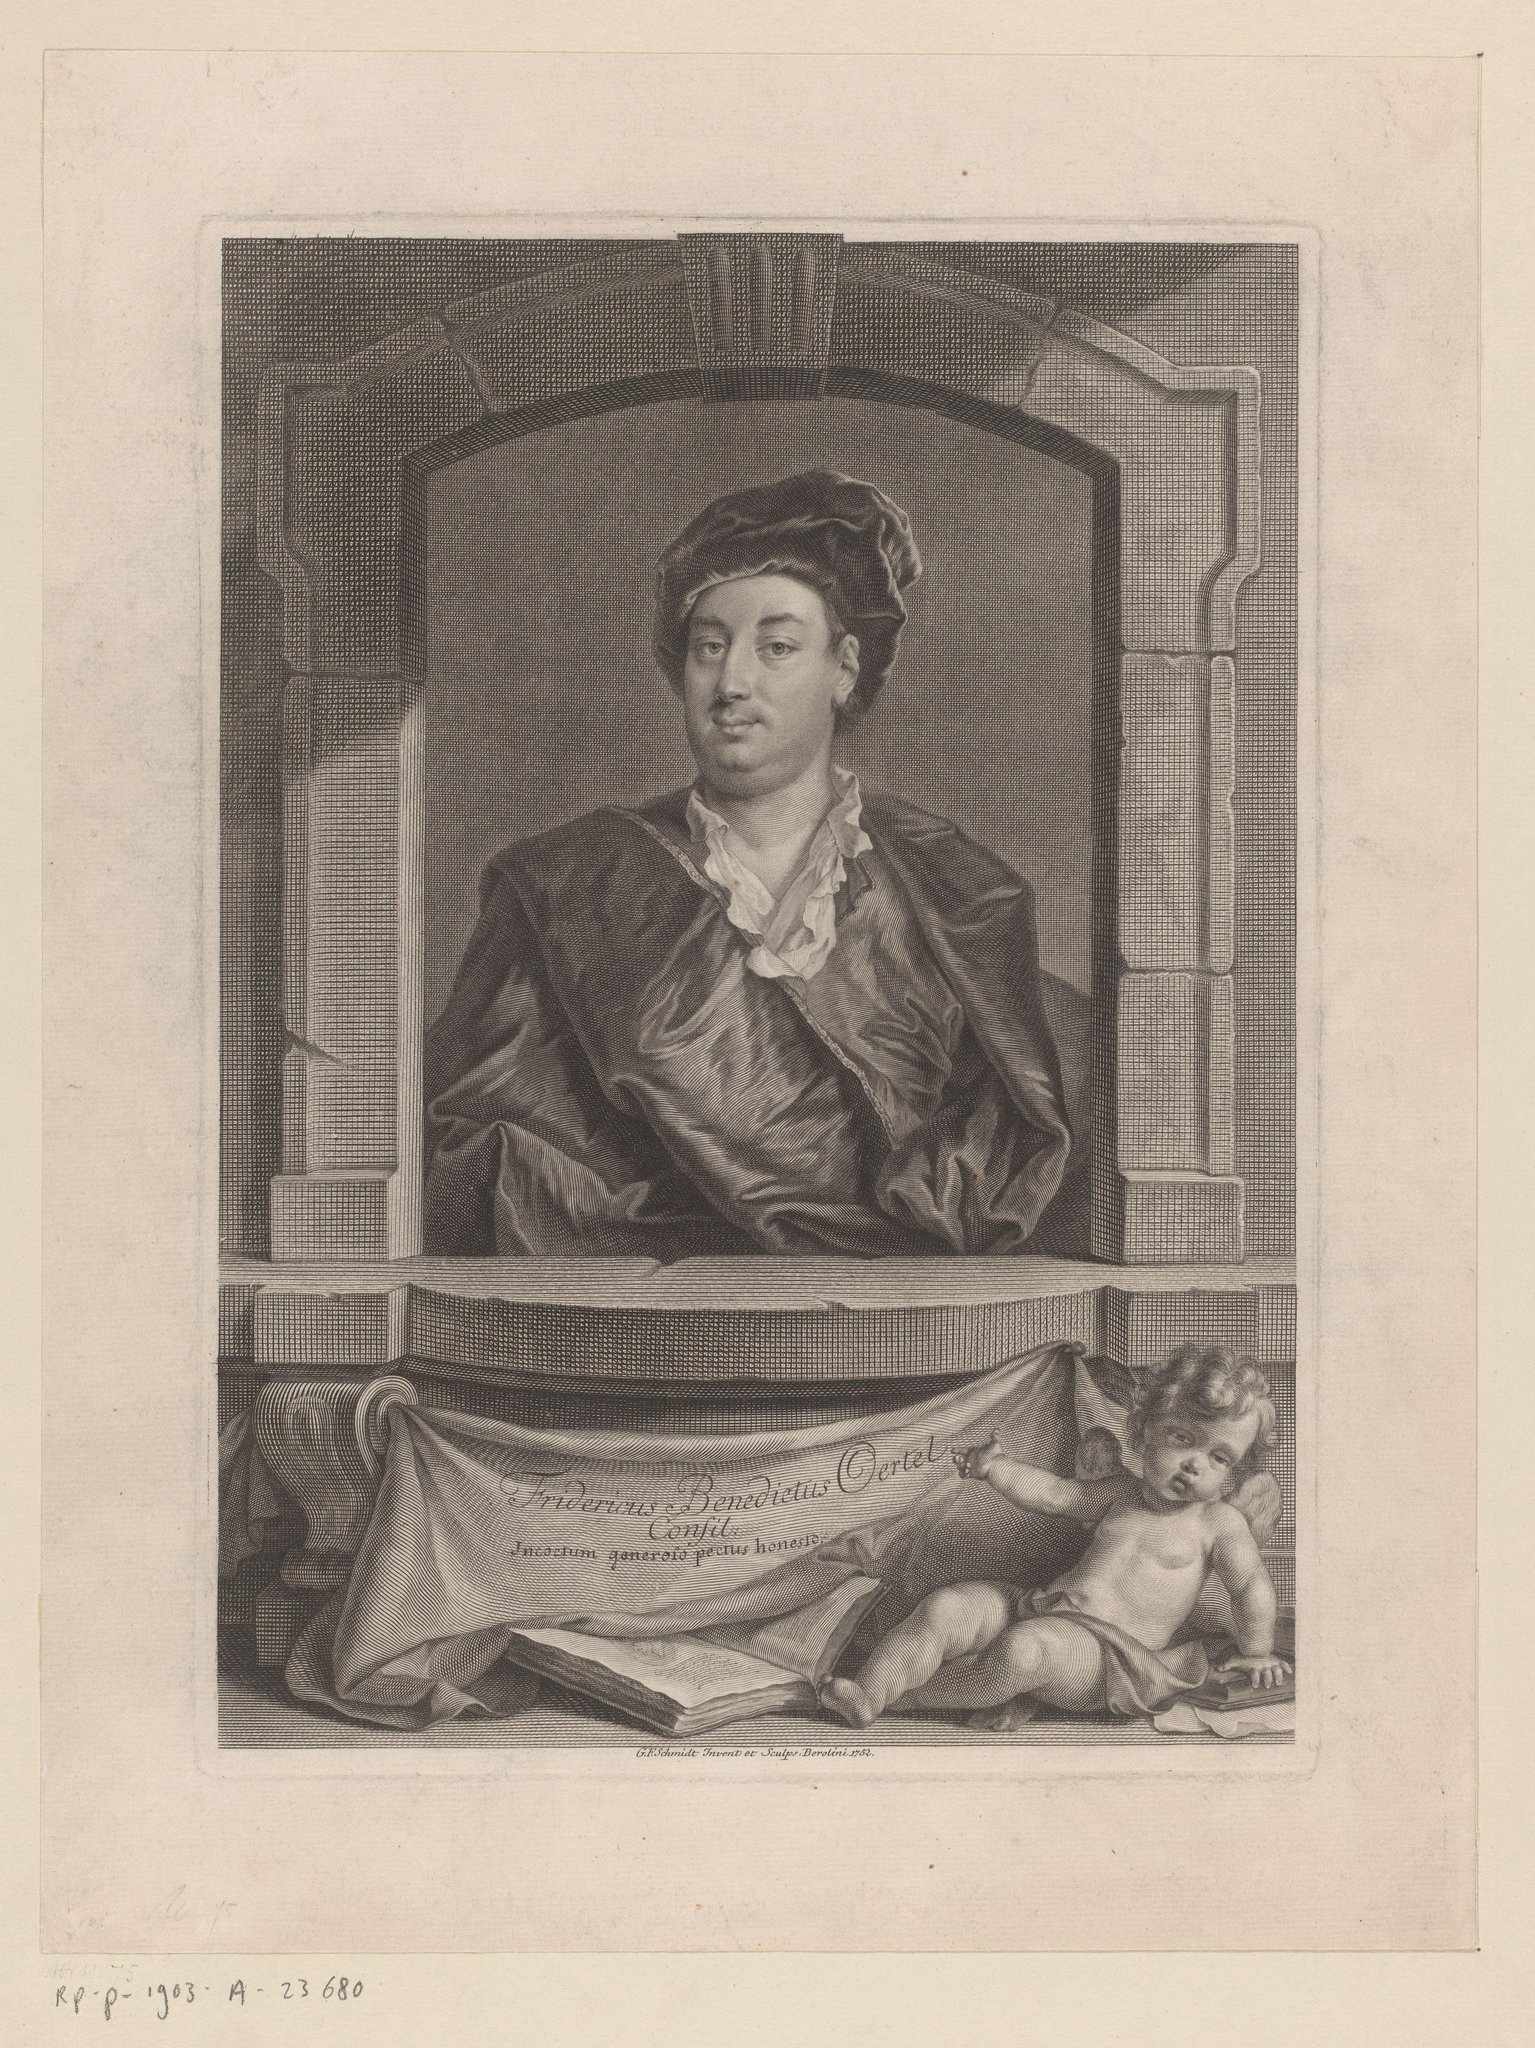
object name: print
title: Portret van Friedrich Benedikt Oertel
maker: georg friedrich schmidt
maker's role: draughtsman, print maker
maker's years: 1712-1775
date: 1752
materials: paper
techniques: engraving, etching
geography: berlin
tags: historical persons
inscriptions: collector's mark: Lugt 2228